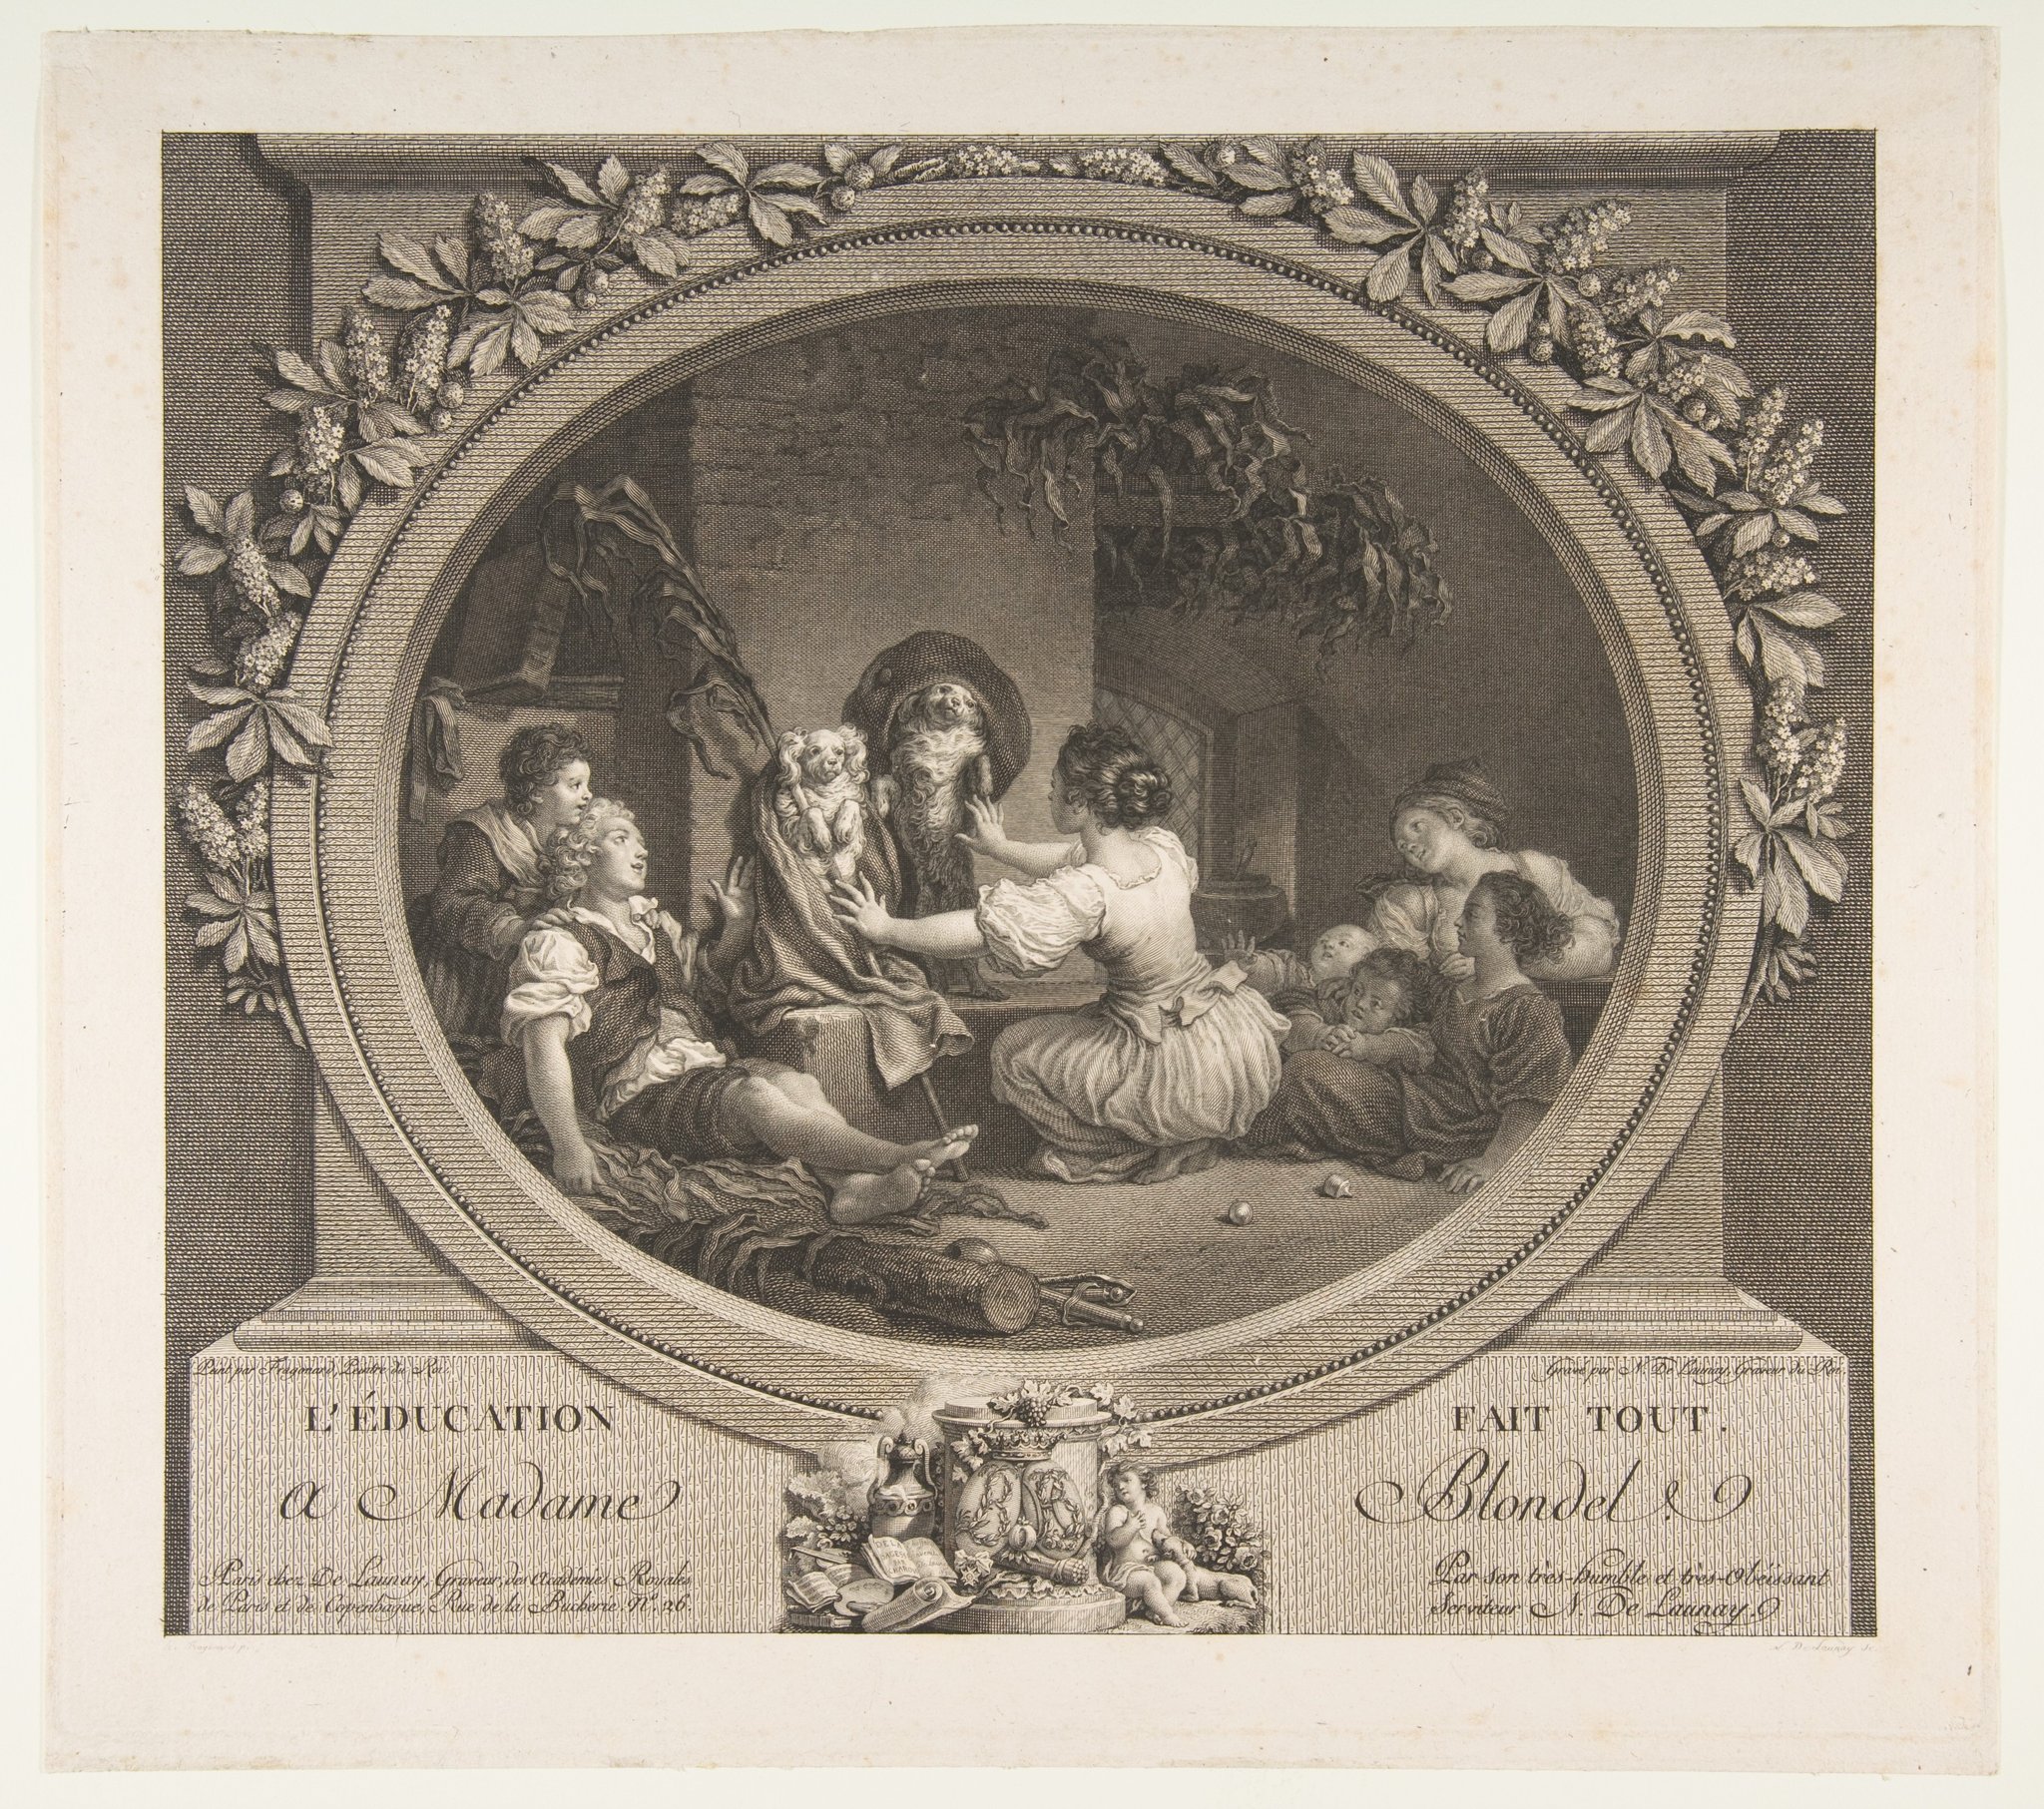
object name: print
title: L'Education fait tout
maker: jean honoré fragonard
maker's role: artist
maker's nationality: french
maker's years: 1732-1806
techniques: etching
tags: boys,girls,women,dogs,leaves